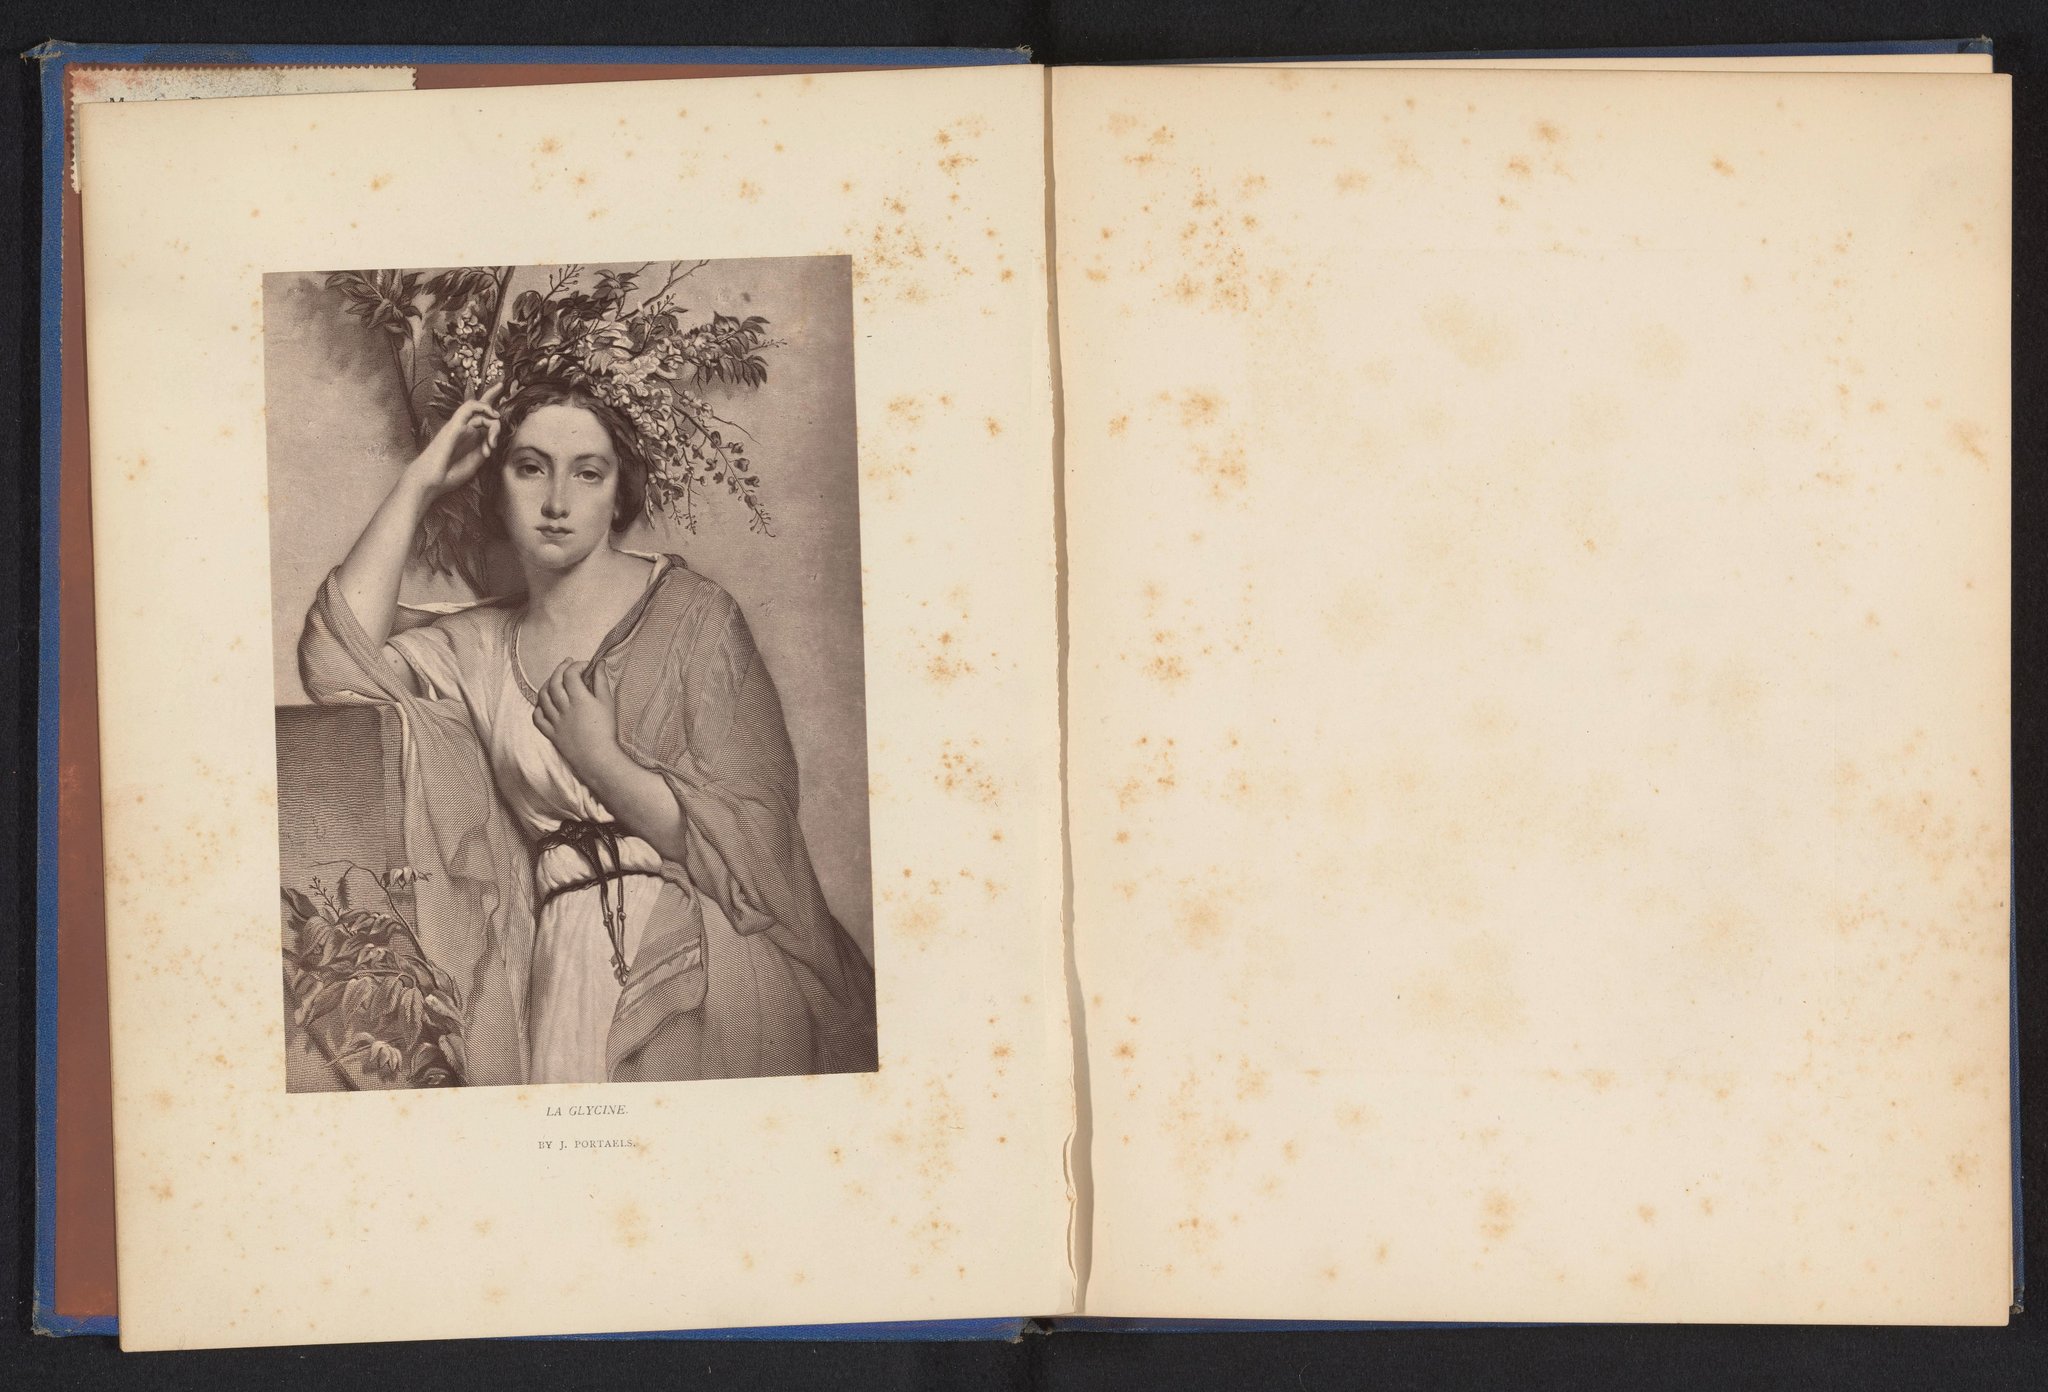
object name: photomechanical print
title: La Glycine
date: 1862-1872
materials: paper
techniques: woodburytype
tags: flowers, adult woman